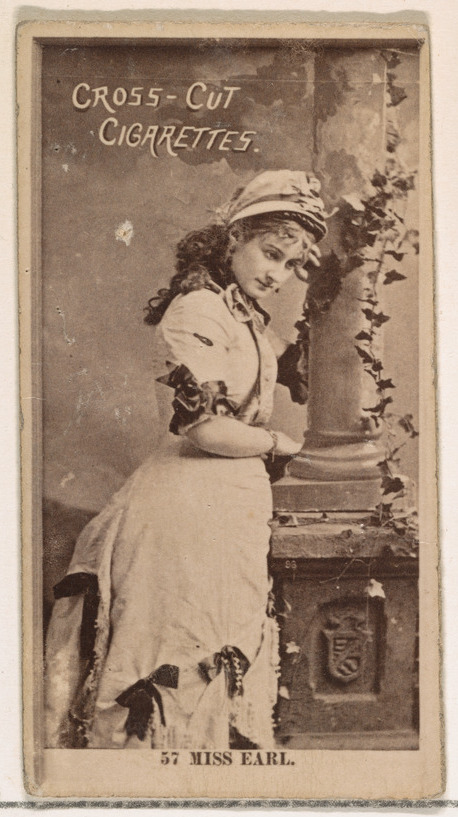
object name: print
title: Card Number 57, Miss Earl, from the Actors and Actresses series (N145-2) issued by Duke Sons & Co. to promote Cross Cut Cigarettes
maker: w. duke, sons & co.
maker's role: publisher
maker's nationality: american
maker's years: 1870-1920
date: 1880-1889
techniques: albumen silver print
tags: portraits,women,actresses